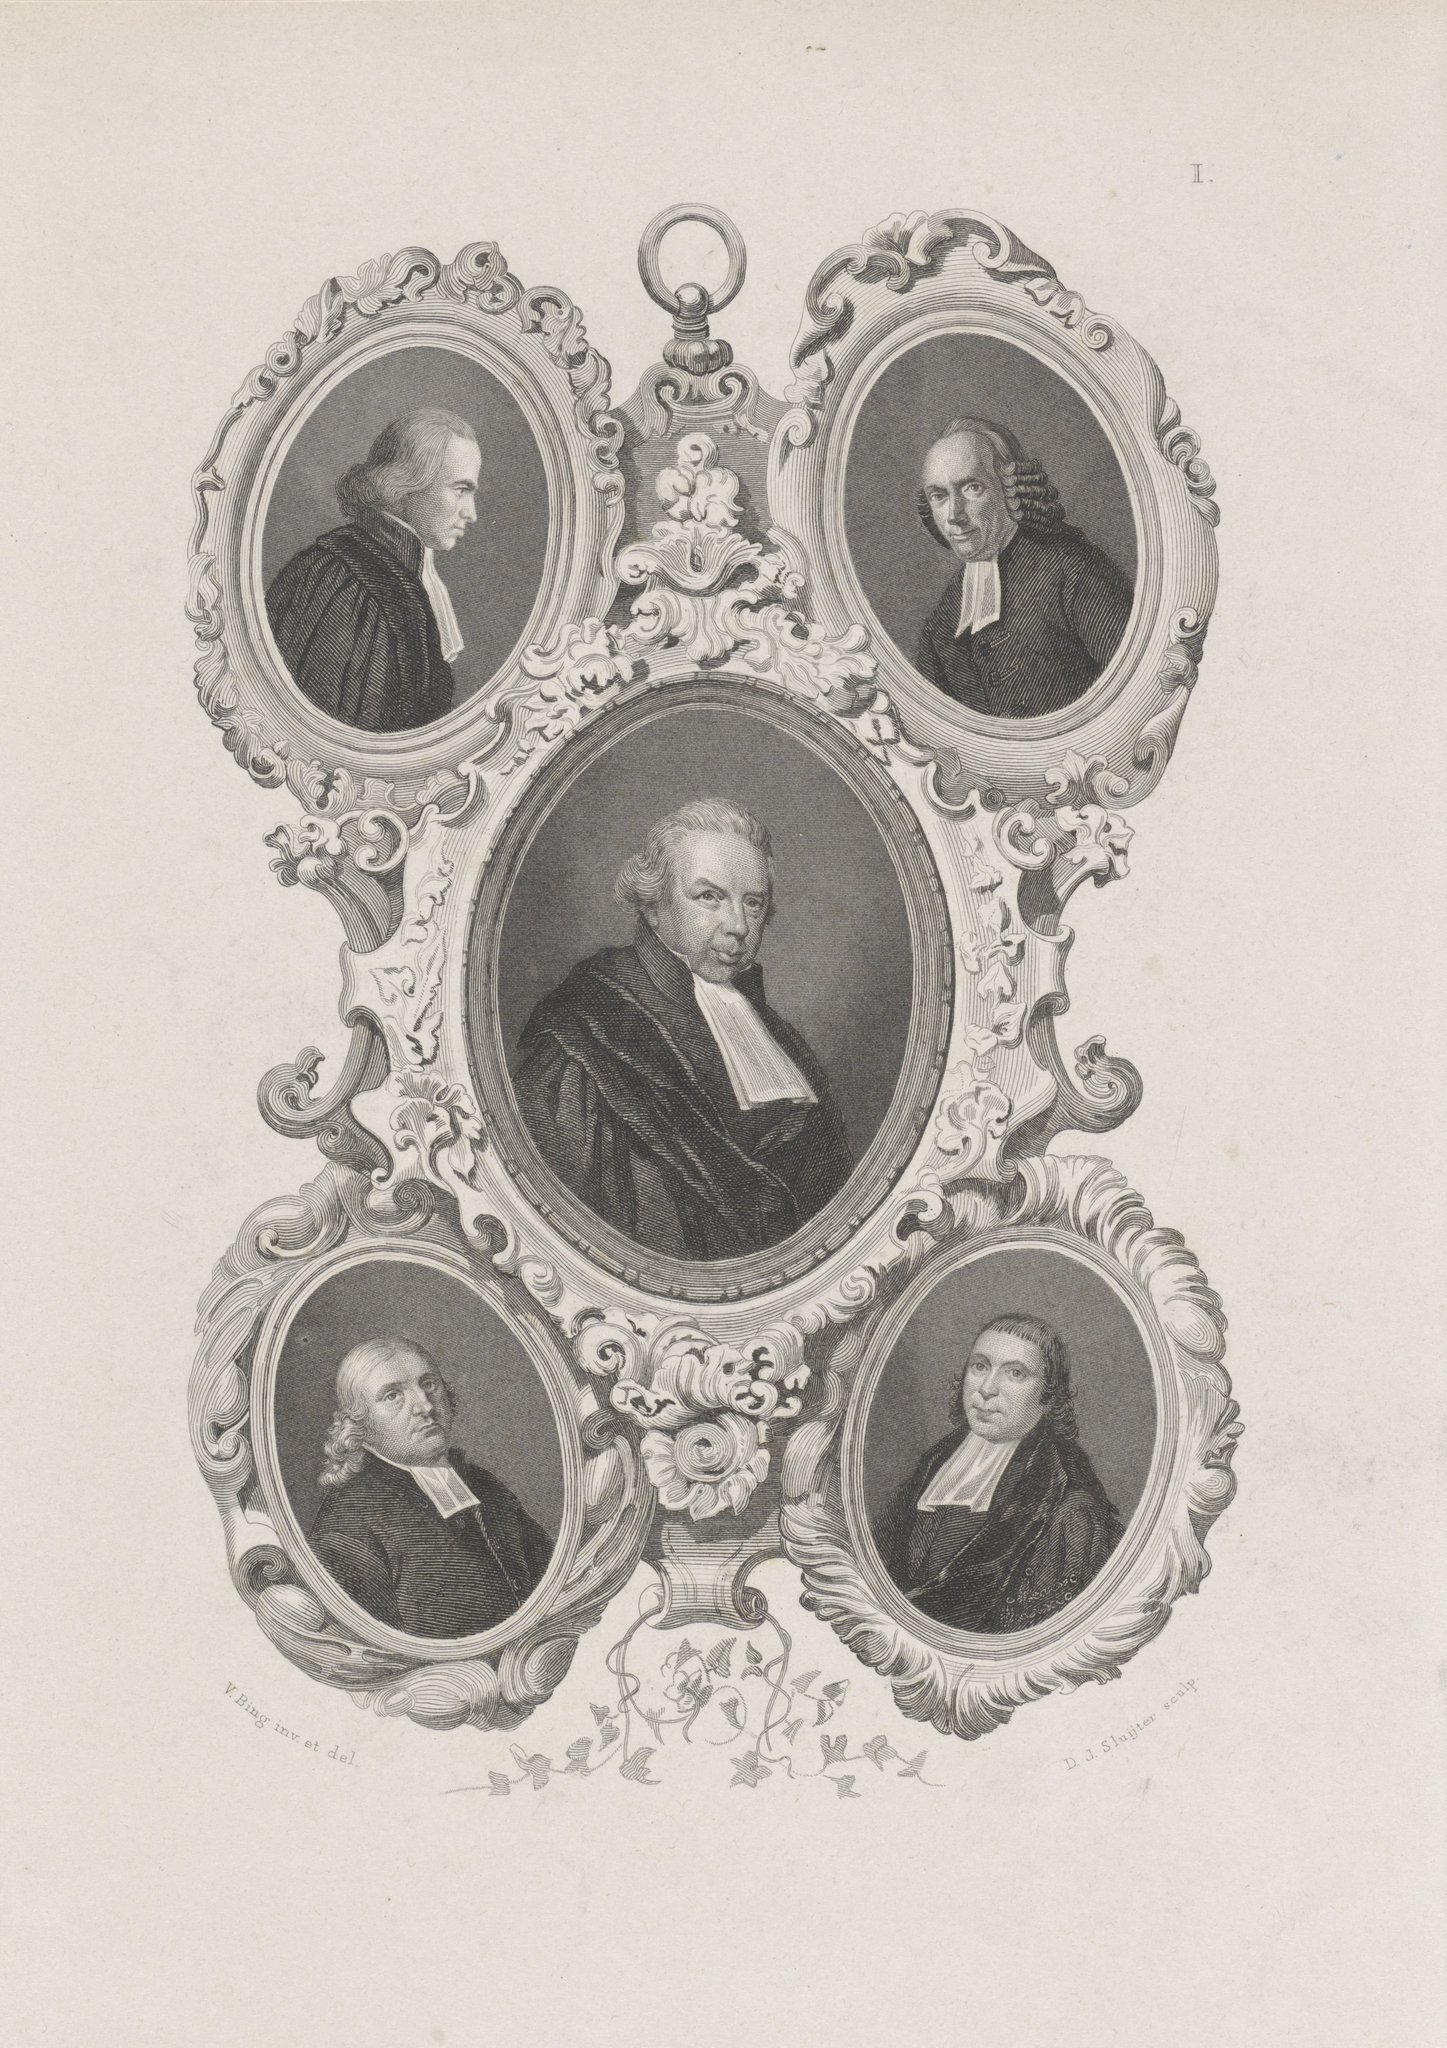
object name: print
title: Vijf portretten in medaillon: Prof. Johannes Clarisse, Prof. Herman Muntinghe, Ds. Johan Diederich Deiman, Prof. Jodocus Heringa en Ds. Ewaldus Kist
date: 1864-1869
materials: paper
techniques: etching, engraving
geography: amsterdam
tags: dordrecht, ewaldus kist, utrecht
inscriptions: collector's mark: Lugt 2228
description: Gebruikt als illustratie in: Bernard ter Haar en Willem Moll (red.). Geschiedenis der christelijke kerk in Nederland, in tafereelen. Amsterdam: 1864-1869.